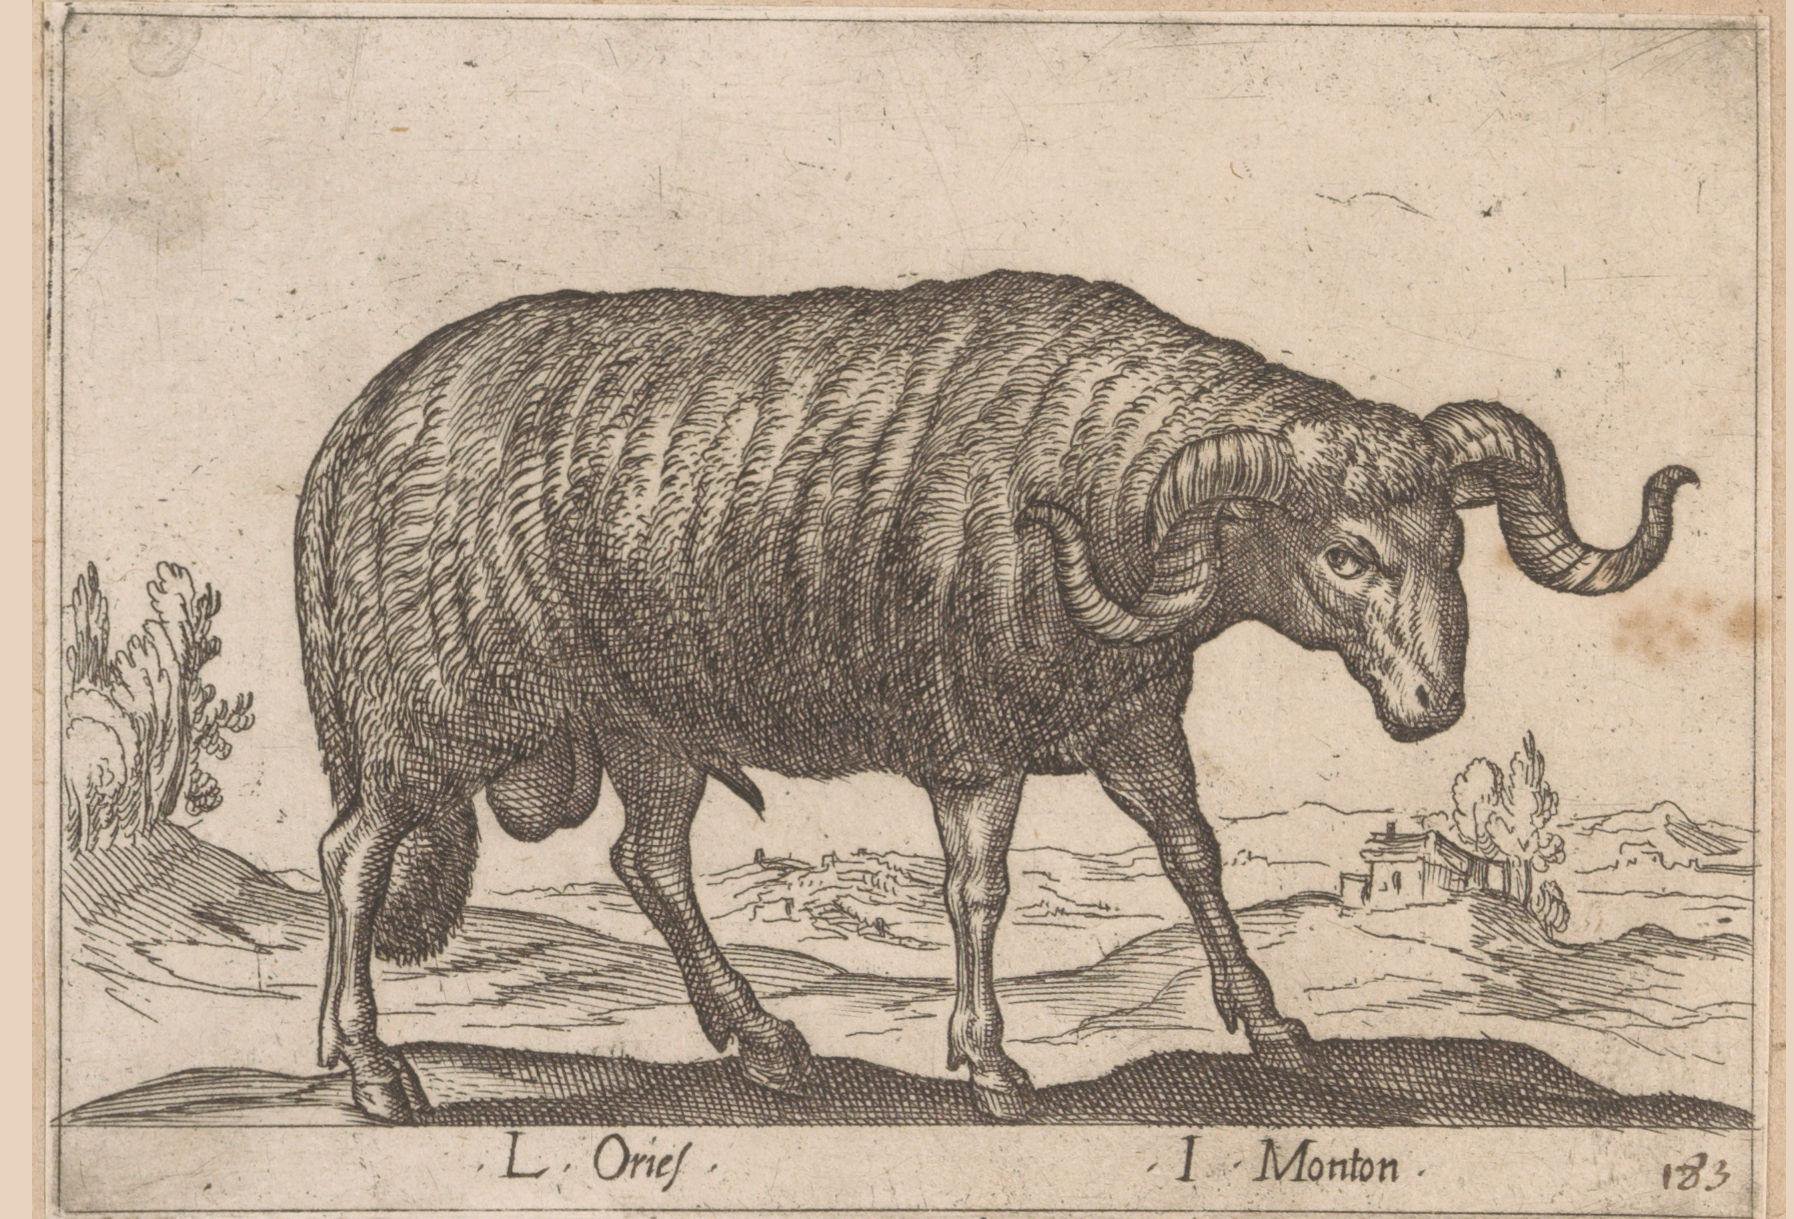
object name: print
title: Dieren en fabelwezens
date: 1565-1630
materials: paper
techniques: etching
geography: rome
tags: ram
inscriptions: number: ‘129’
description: Deze prent maakt deel uit van een reeks prenten van dieren door Antonio Tempesta. Bekend is dat een tweede staat (met nummering) van deze serie is uitgegeven door Giovanni Giacomo de' Rossi in 1650. Onbekend is wie de eerste staat heeft uitgegeven en wanneer.